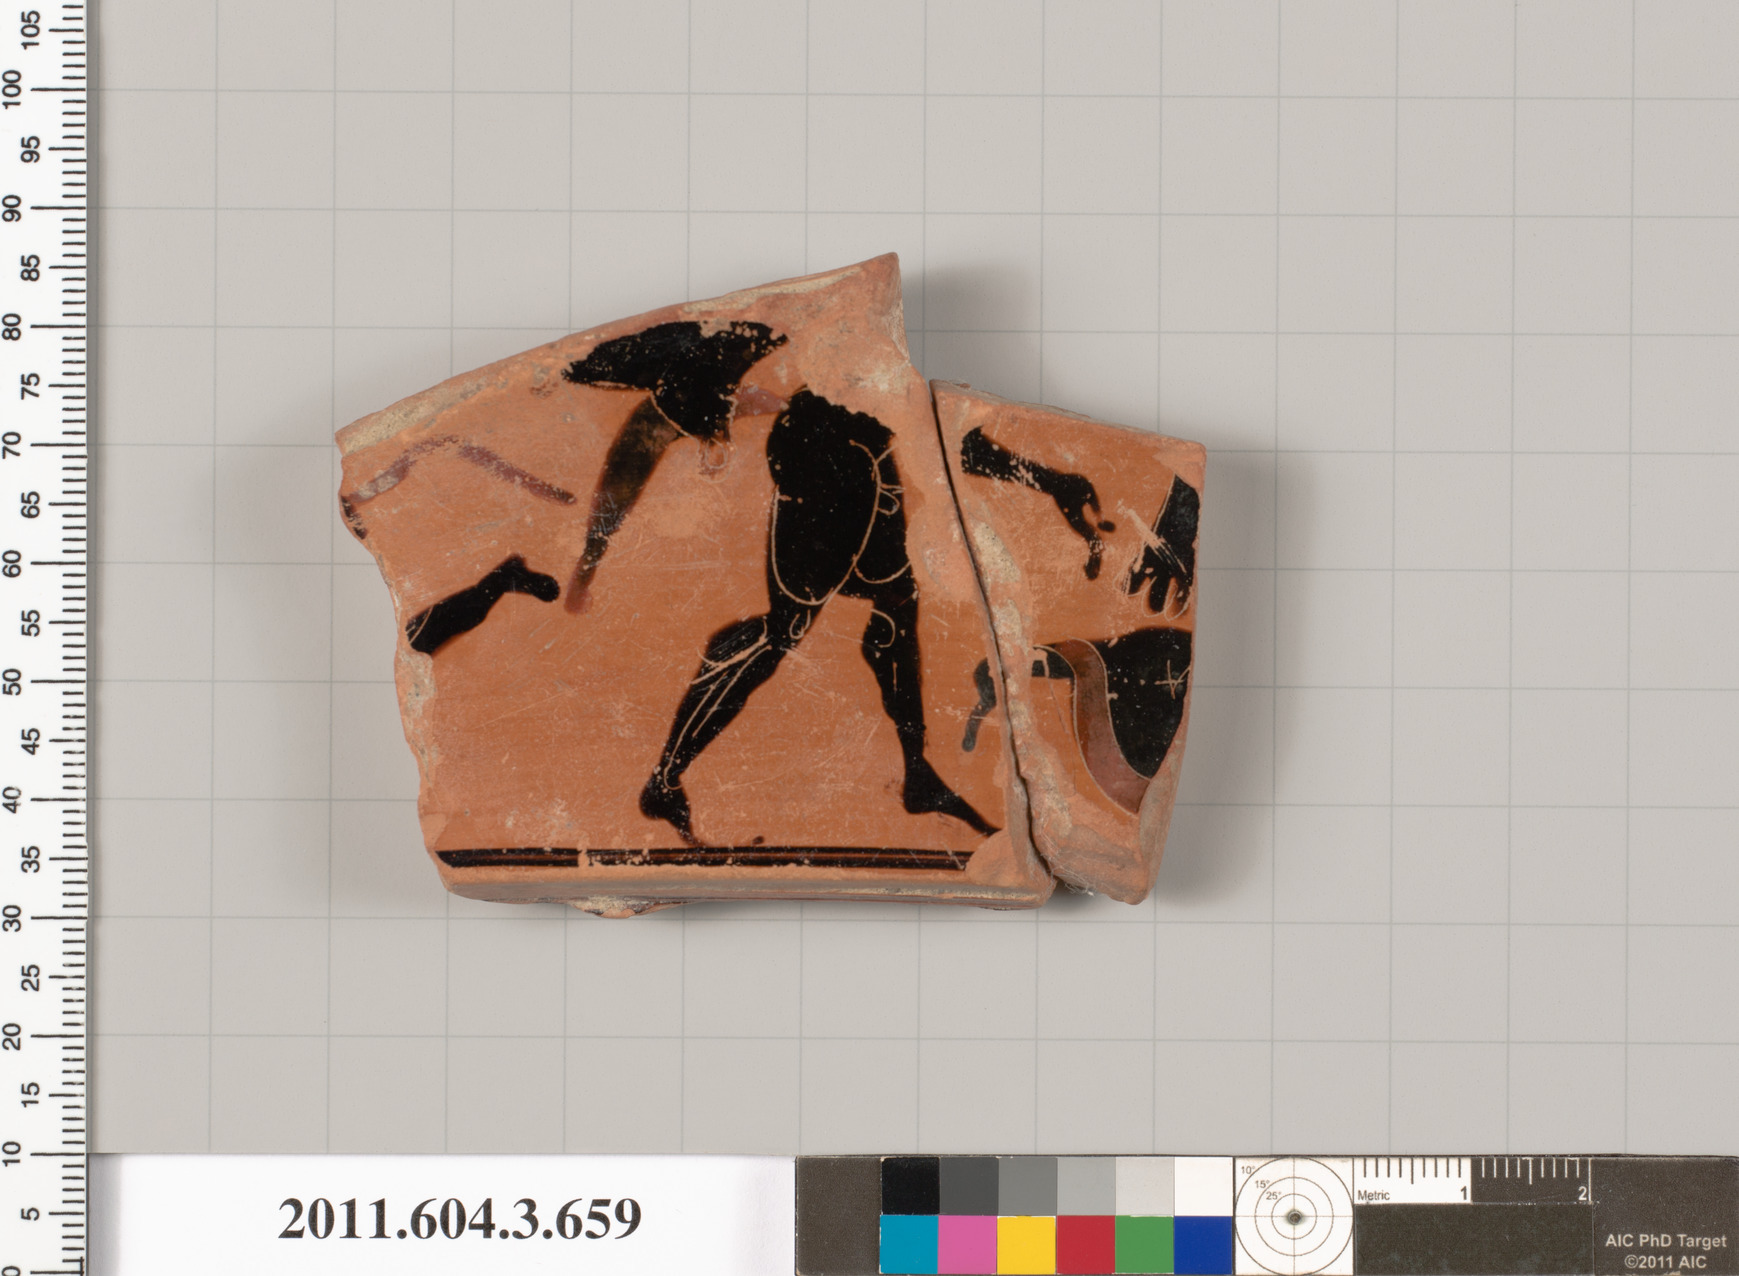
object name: volute krater fragment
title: Terracotta fragment of a volute-krater (bowl for mixing wine and water)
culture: greek, attic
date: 510-500 BCE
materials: terracotta